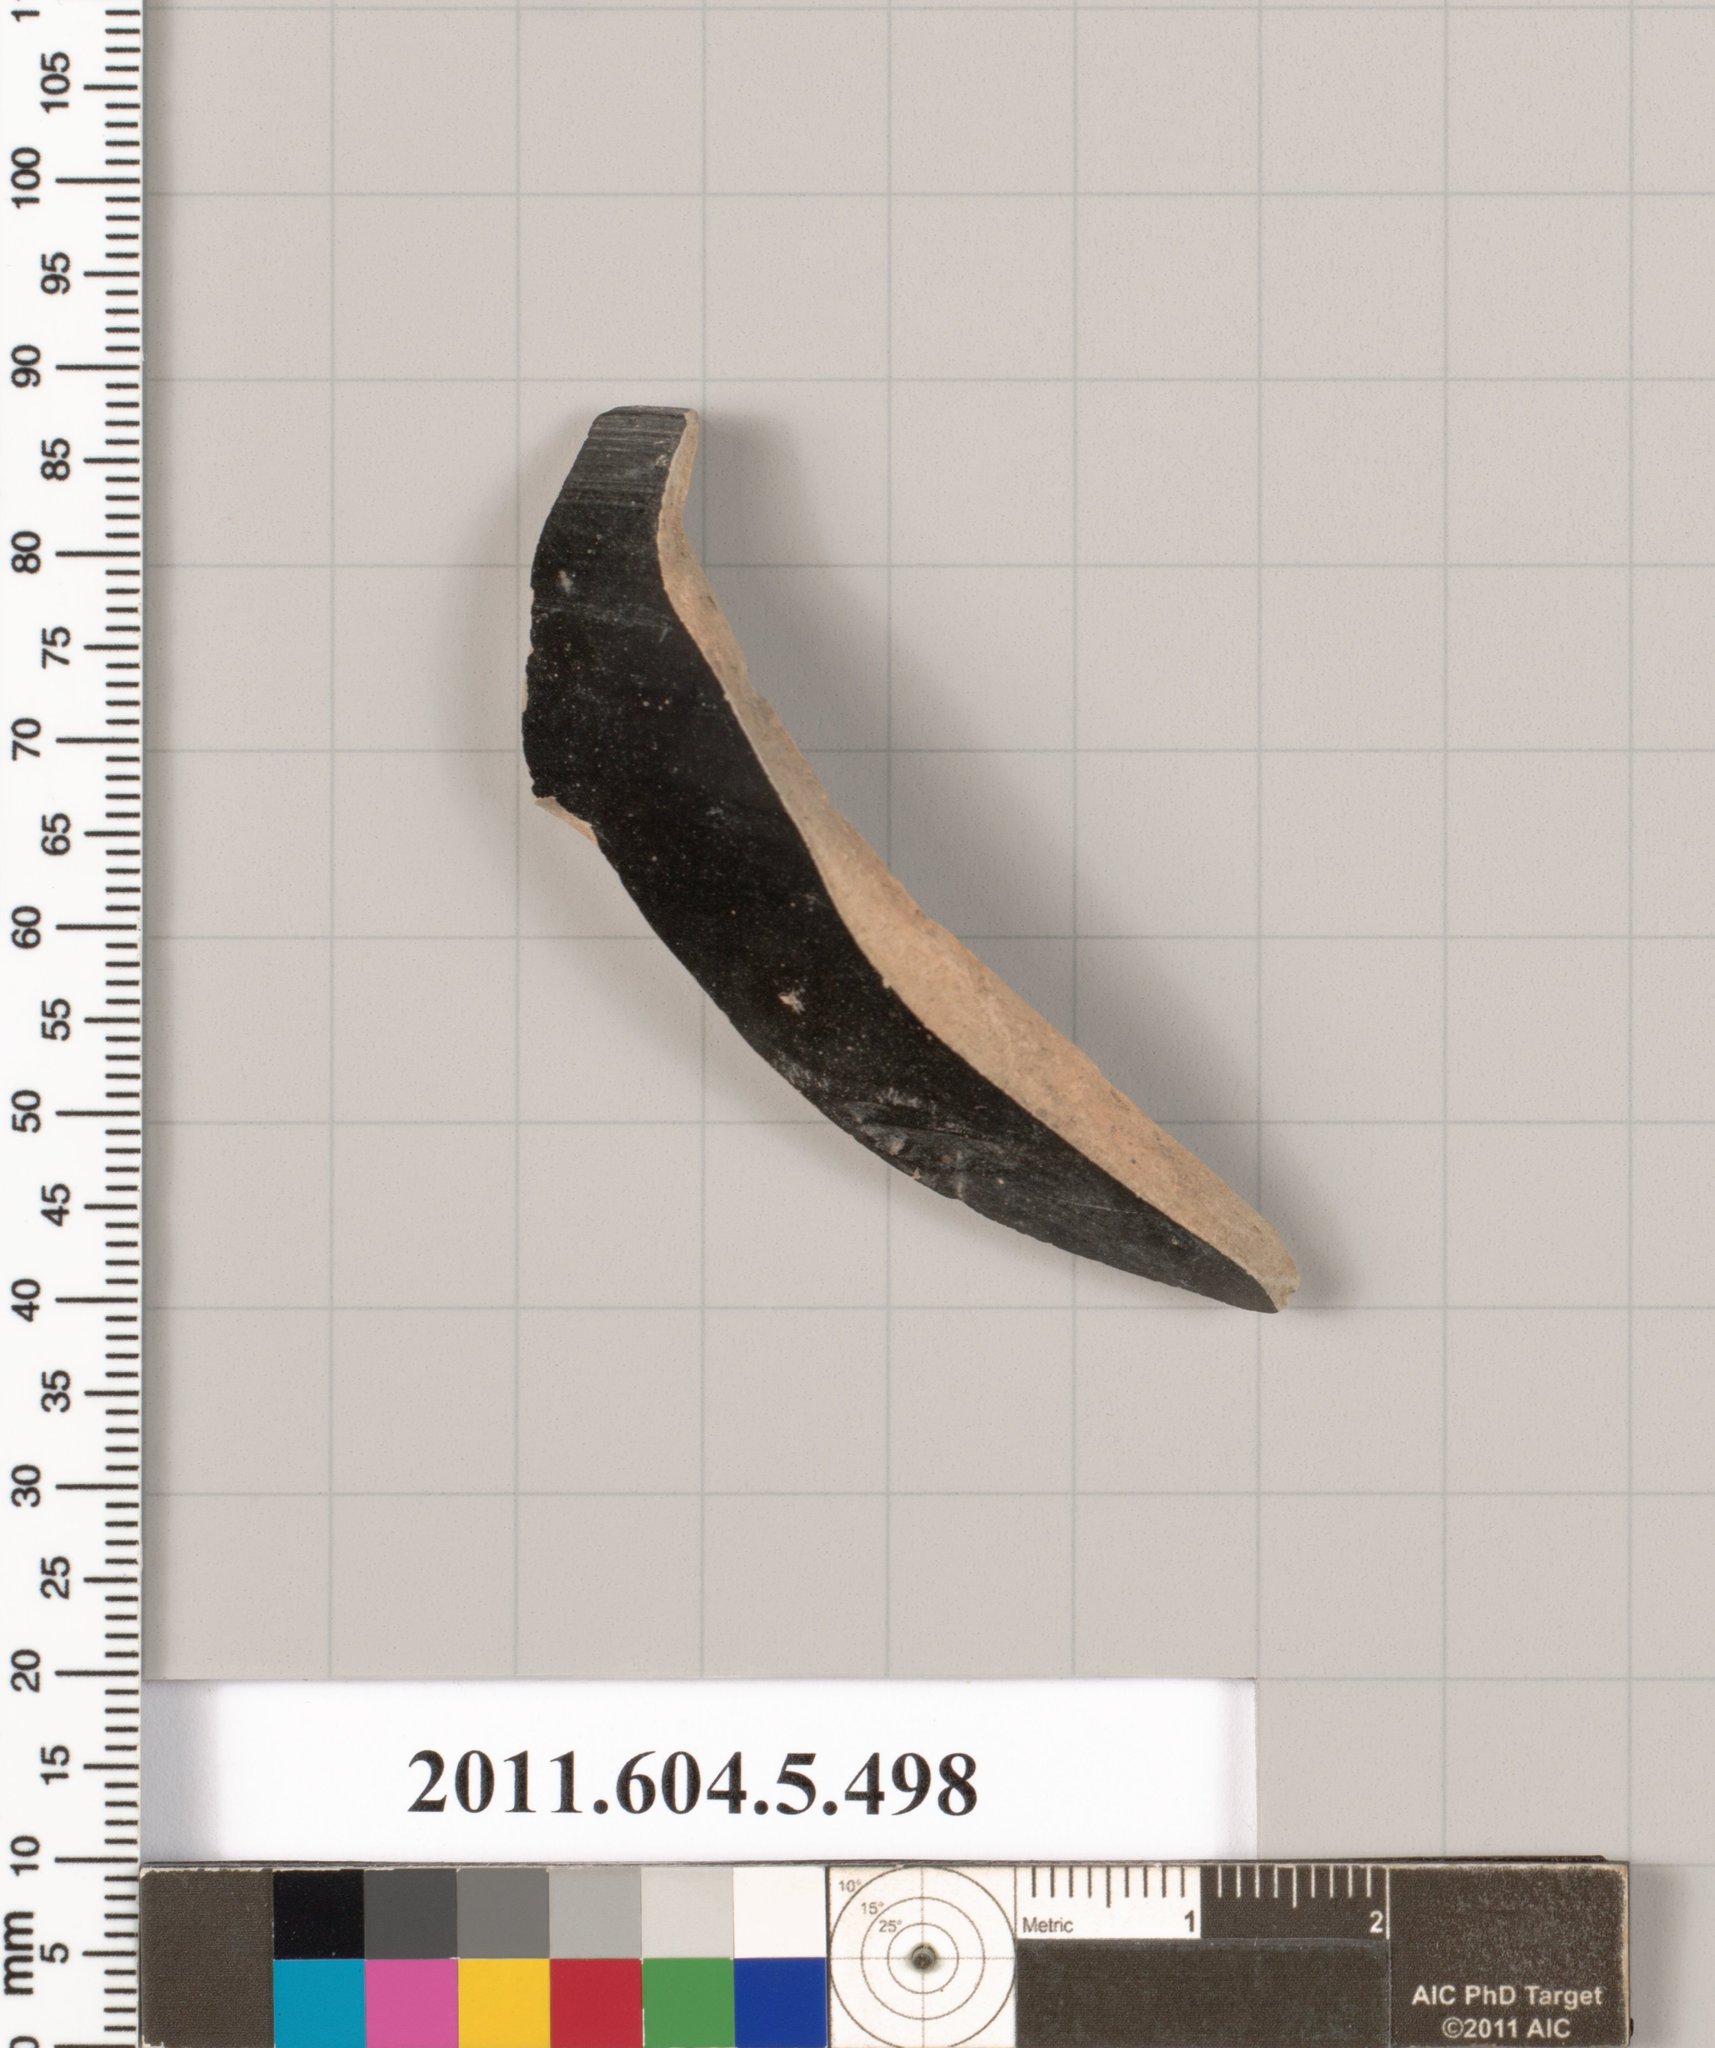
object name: kylix fragment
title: Terracotta rim fragment of a kylix (drinking cup)?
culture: greek, attic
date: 600-401 BCE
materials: terracotta